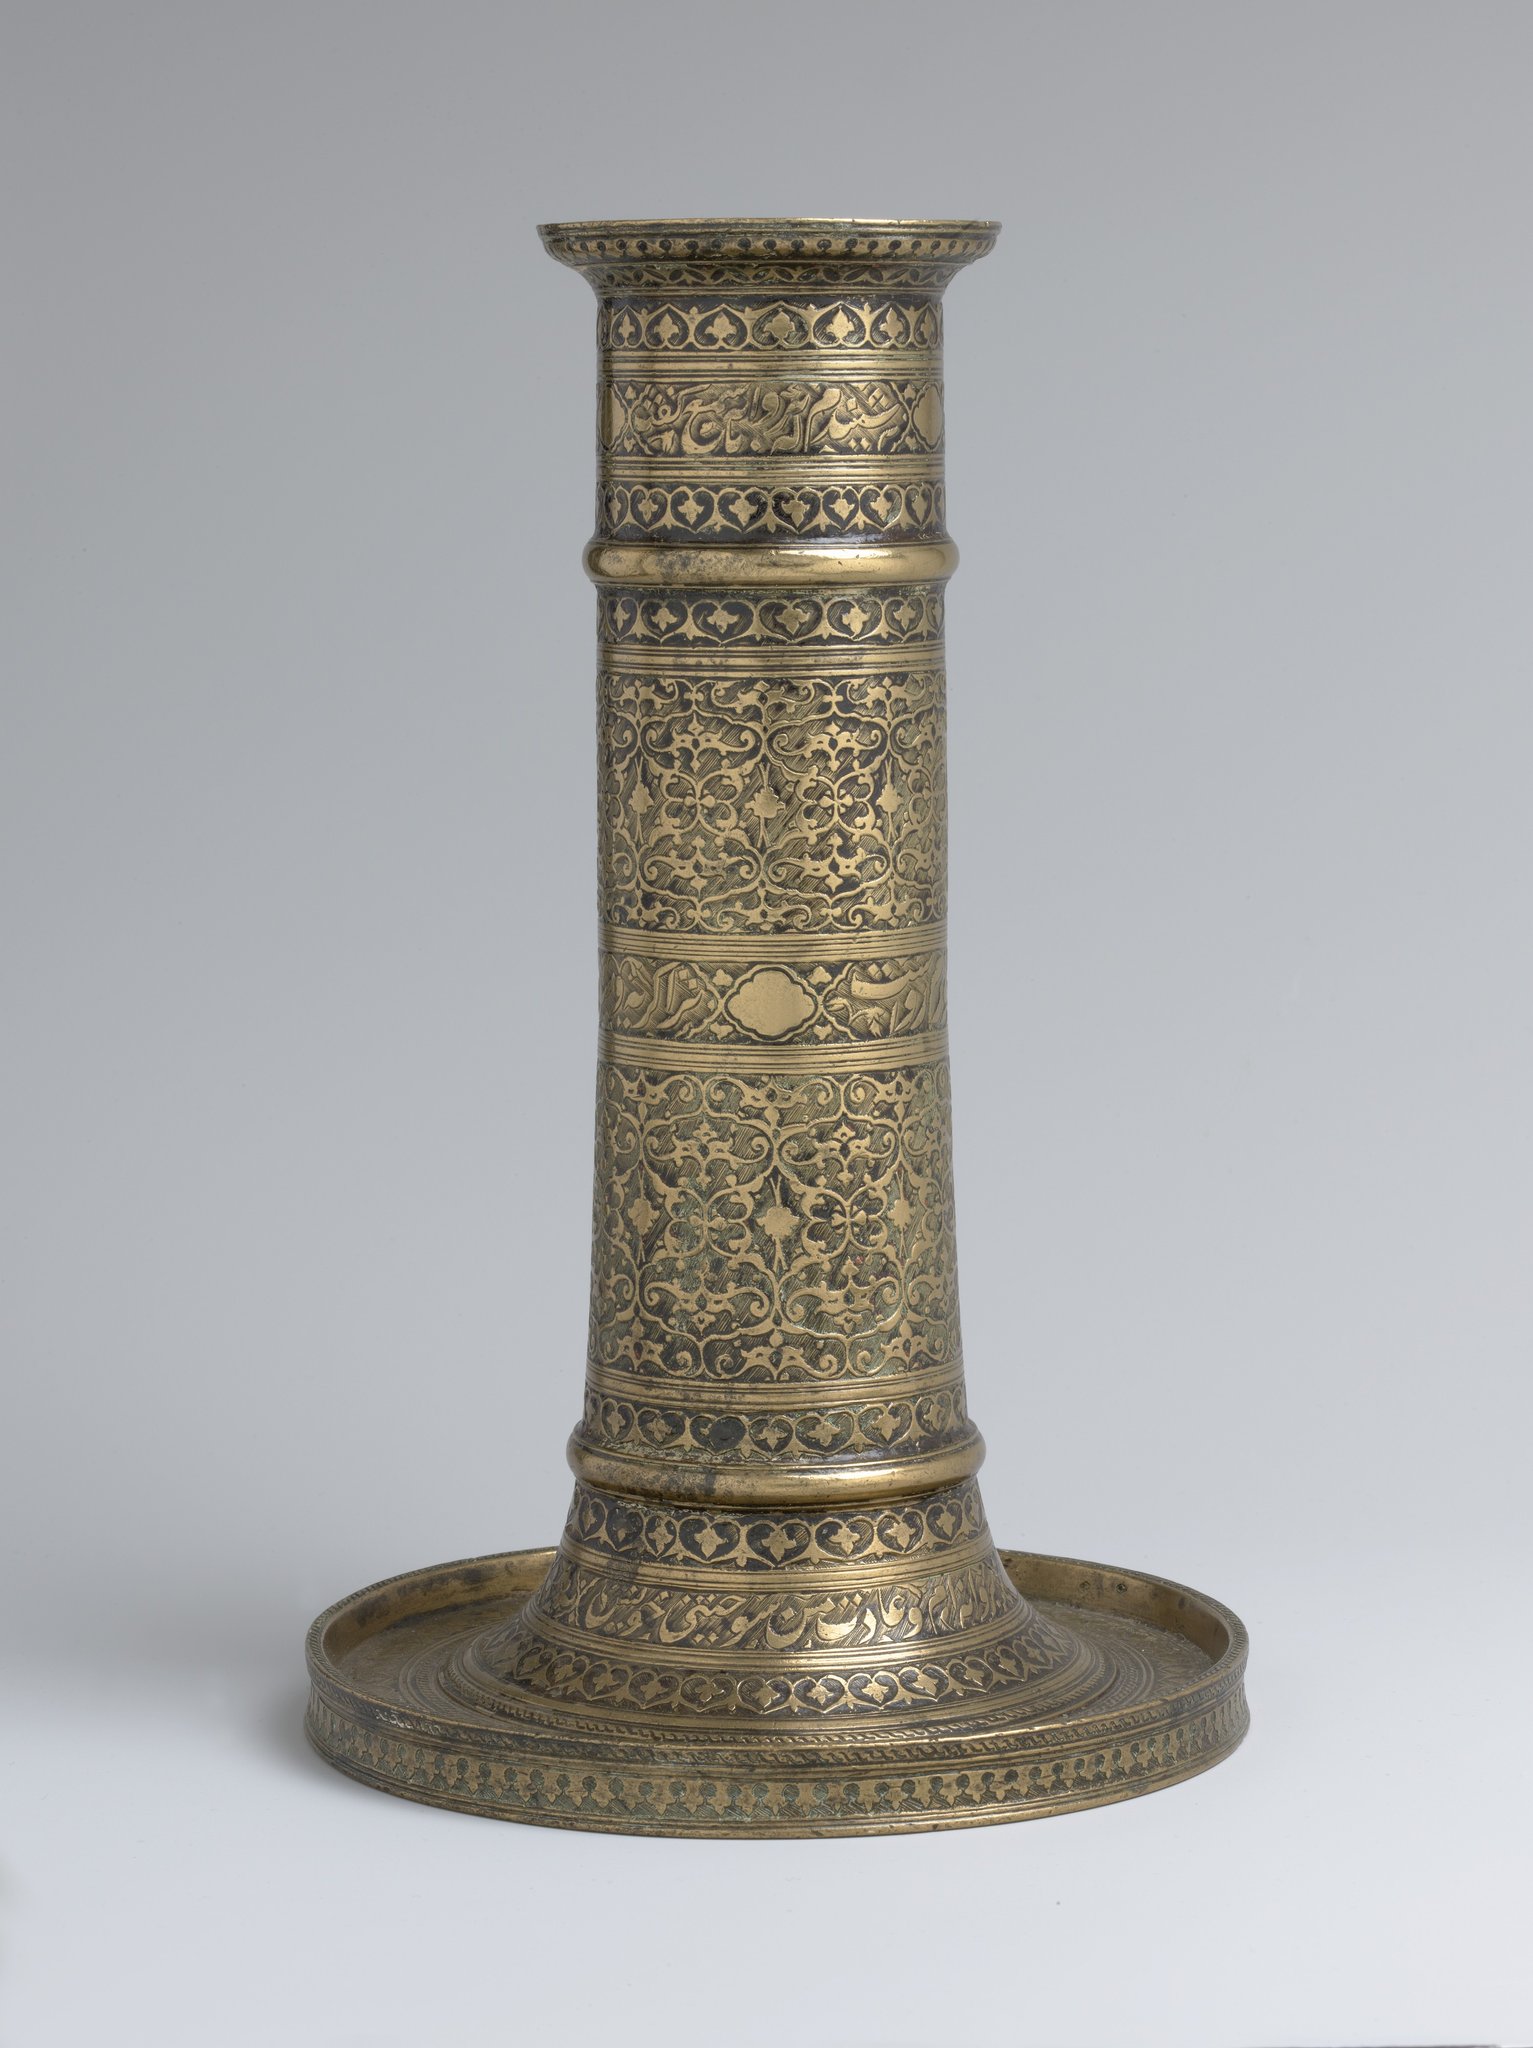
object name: lampstand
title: Lamp Stand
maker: abdullah haidar al-husaini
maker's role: dedicatee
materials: brass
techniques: casting, engraving, inlay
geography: iran